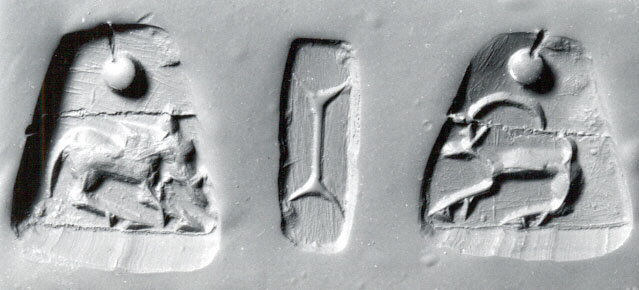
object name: stamp seal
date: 2000-1001 BCE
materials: limestone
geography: central asia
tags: animals